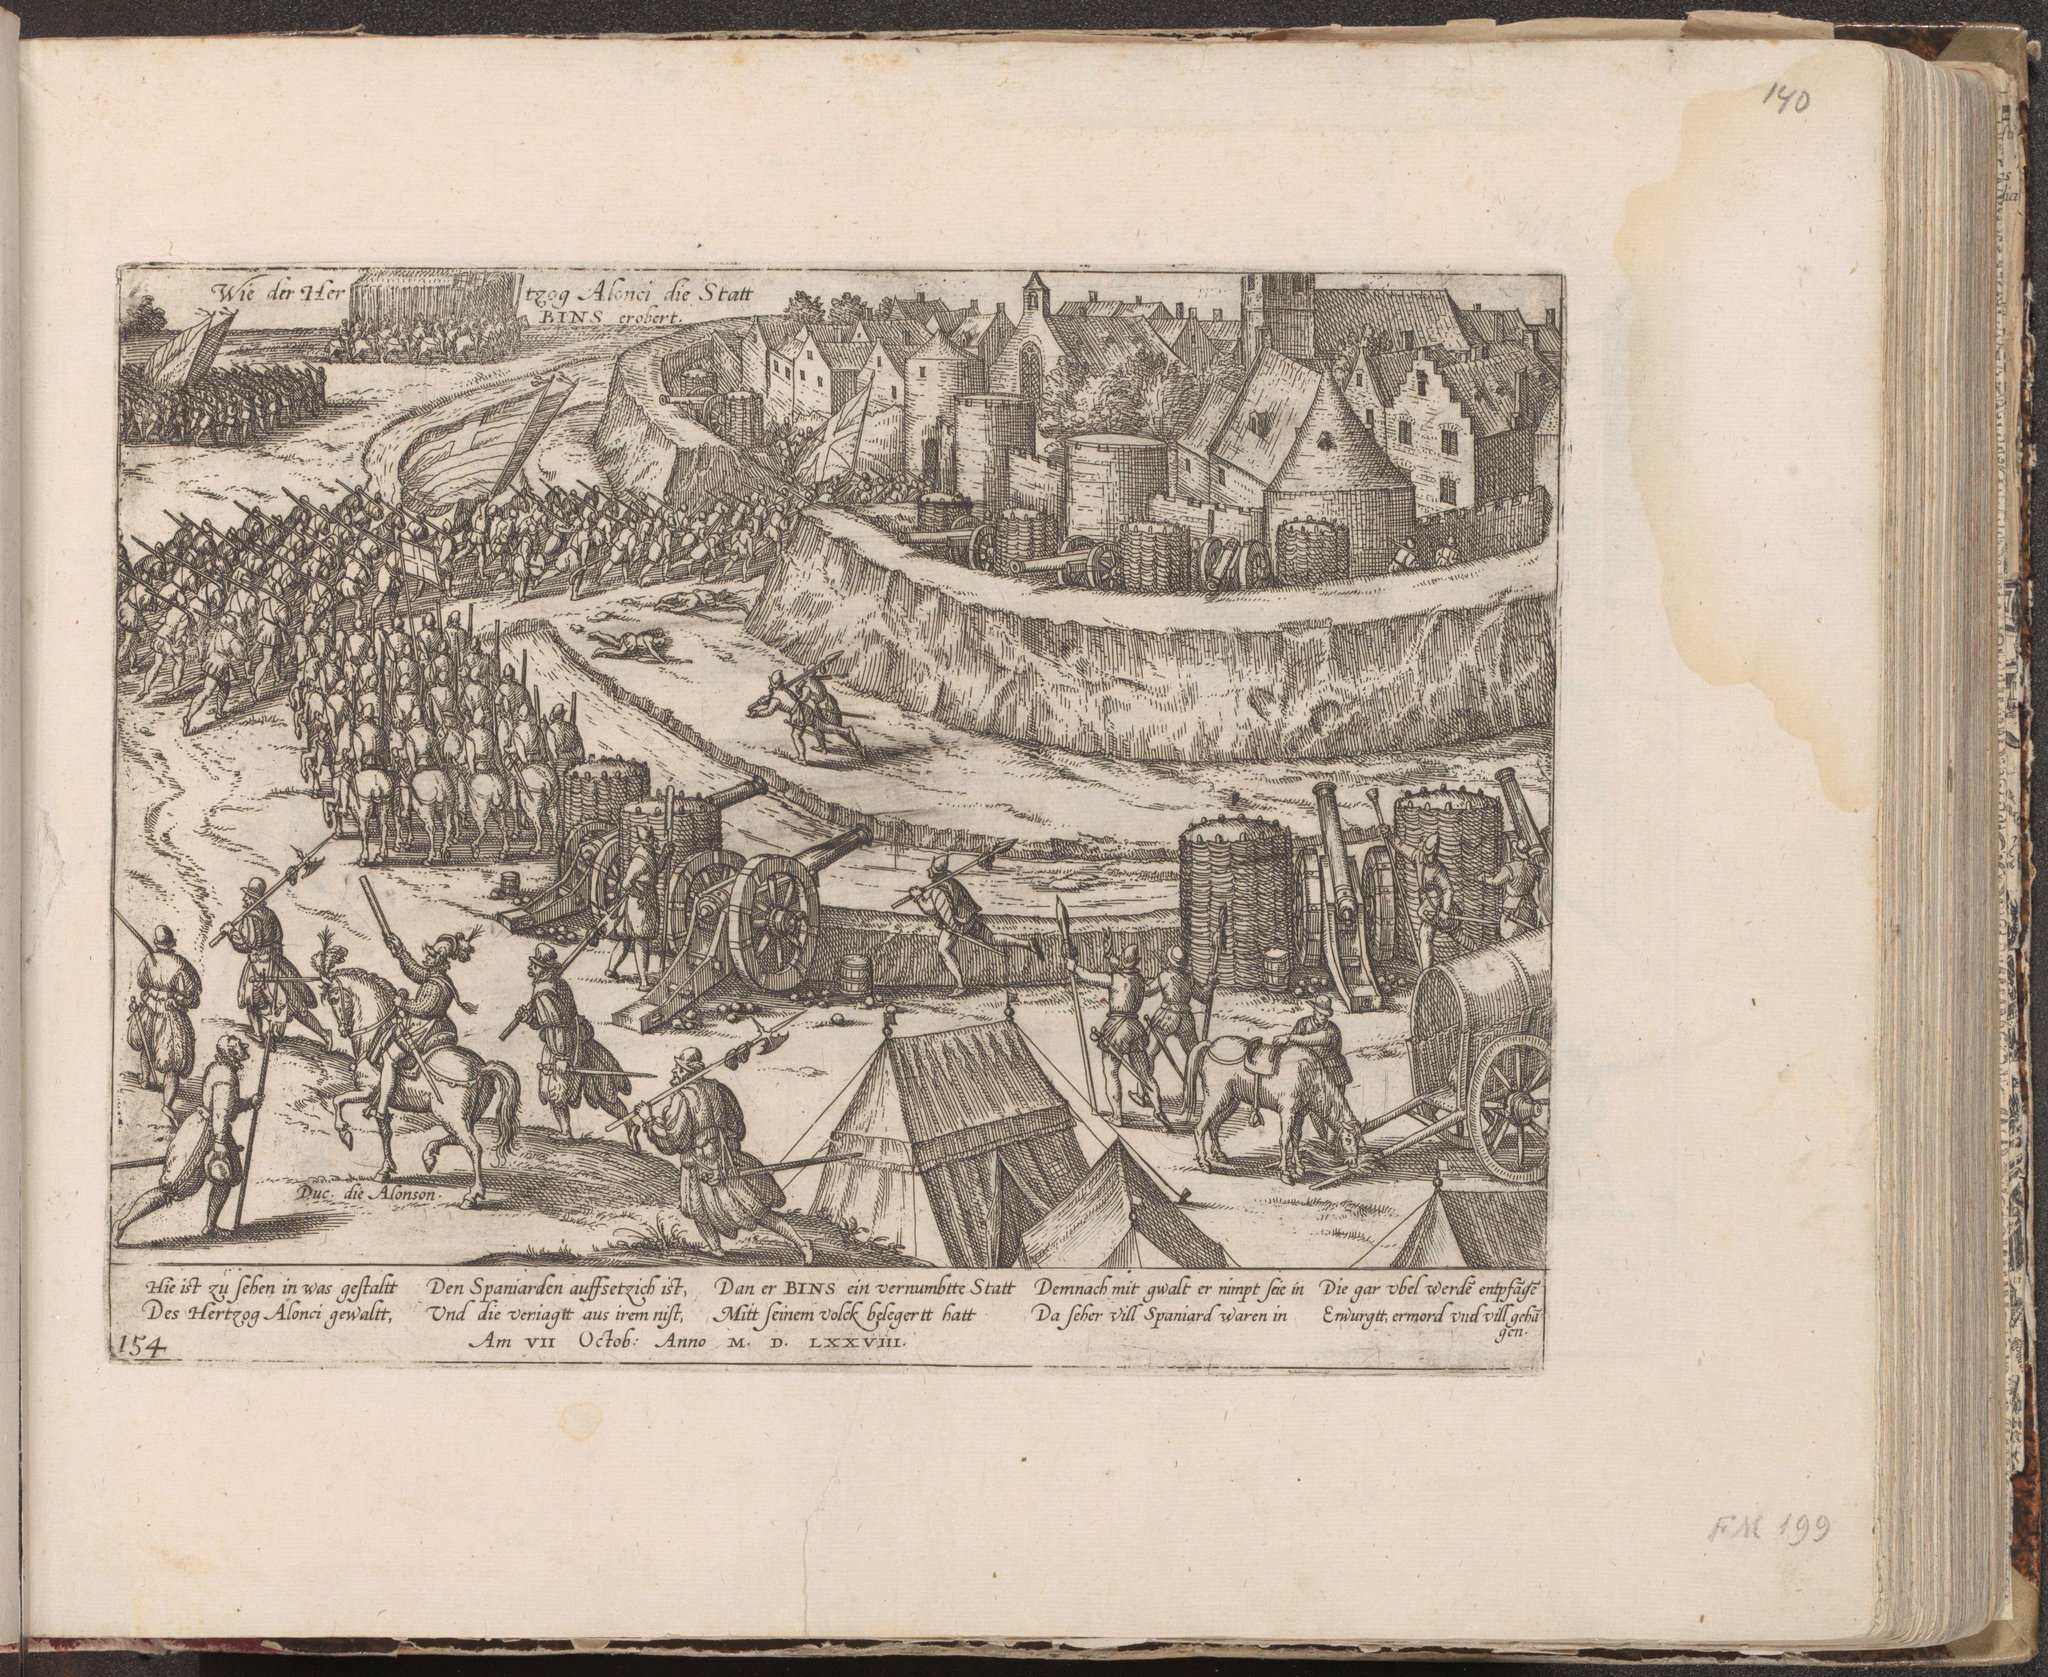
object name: album leaf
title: Hertog van Anjou neemt Binche in, 1578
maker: frans hogenberg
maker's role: print maker, publisher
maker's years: 1538-1590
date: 1581-1585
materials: paper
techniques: etching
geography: cologne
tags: françois-hercule de valois (hertog van anjou), capture of city (after the siege), binche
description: Na beleg geeft de stad Binche in Henegouwen zich over aan de hertog van Anjou, 7 oktober 1578. Op de voorgrond de hertog van Anjou te paard, boven trekken zijn legers de stad in. Met onderschrift van 10 regels in het Duits. Linksonder genummerd: 154. De prent maakt deel uit van een album.